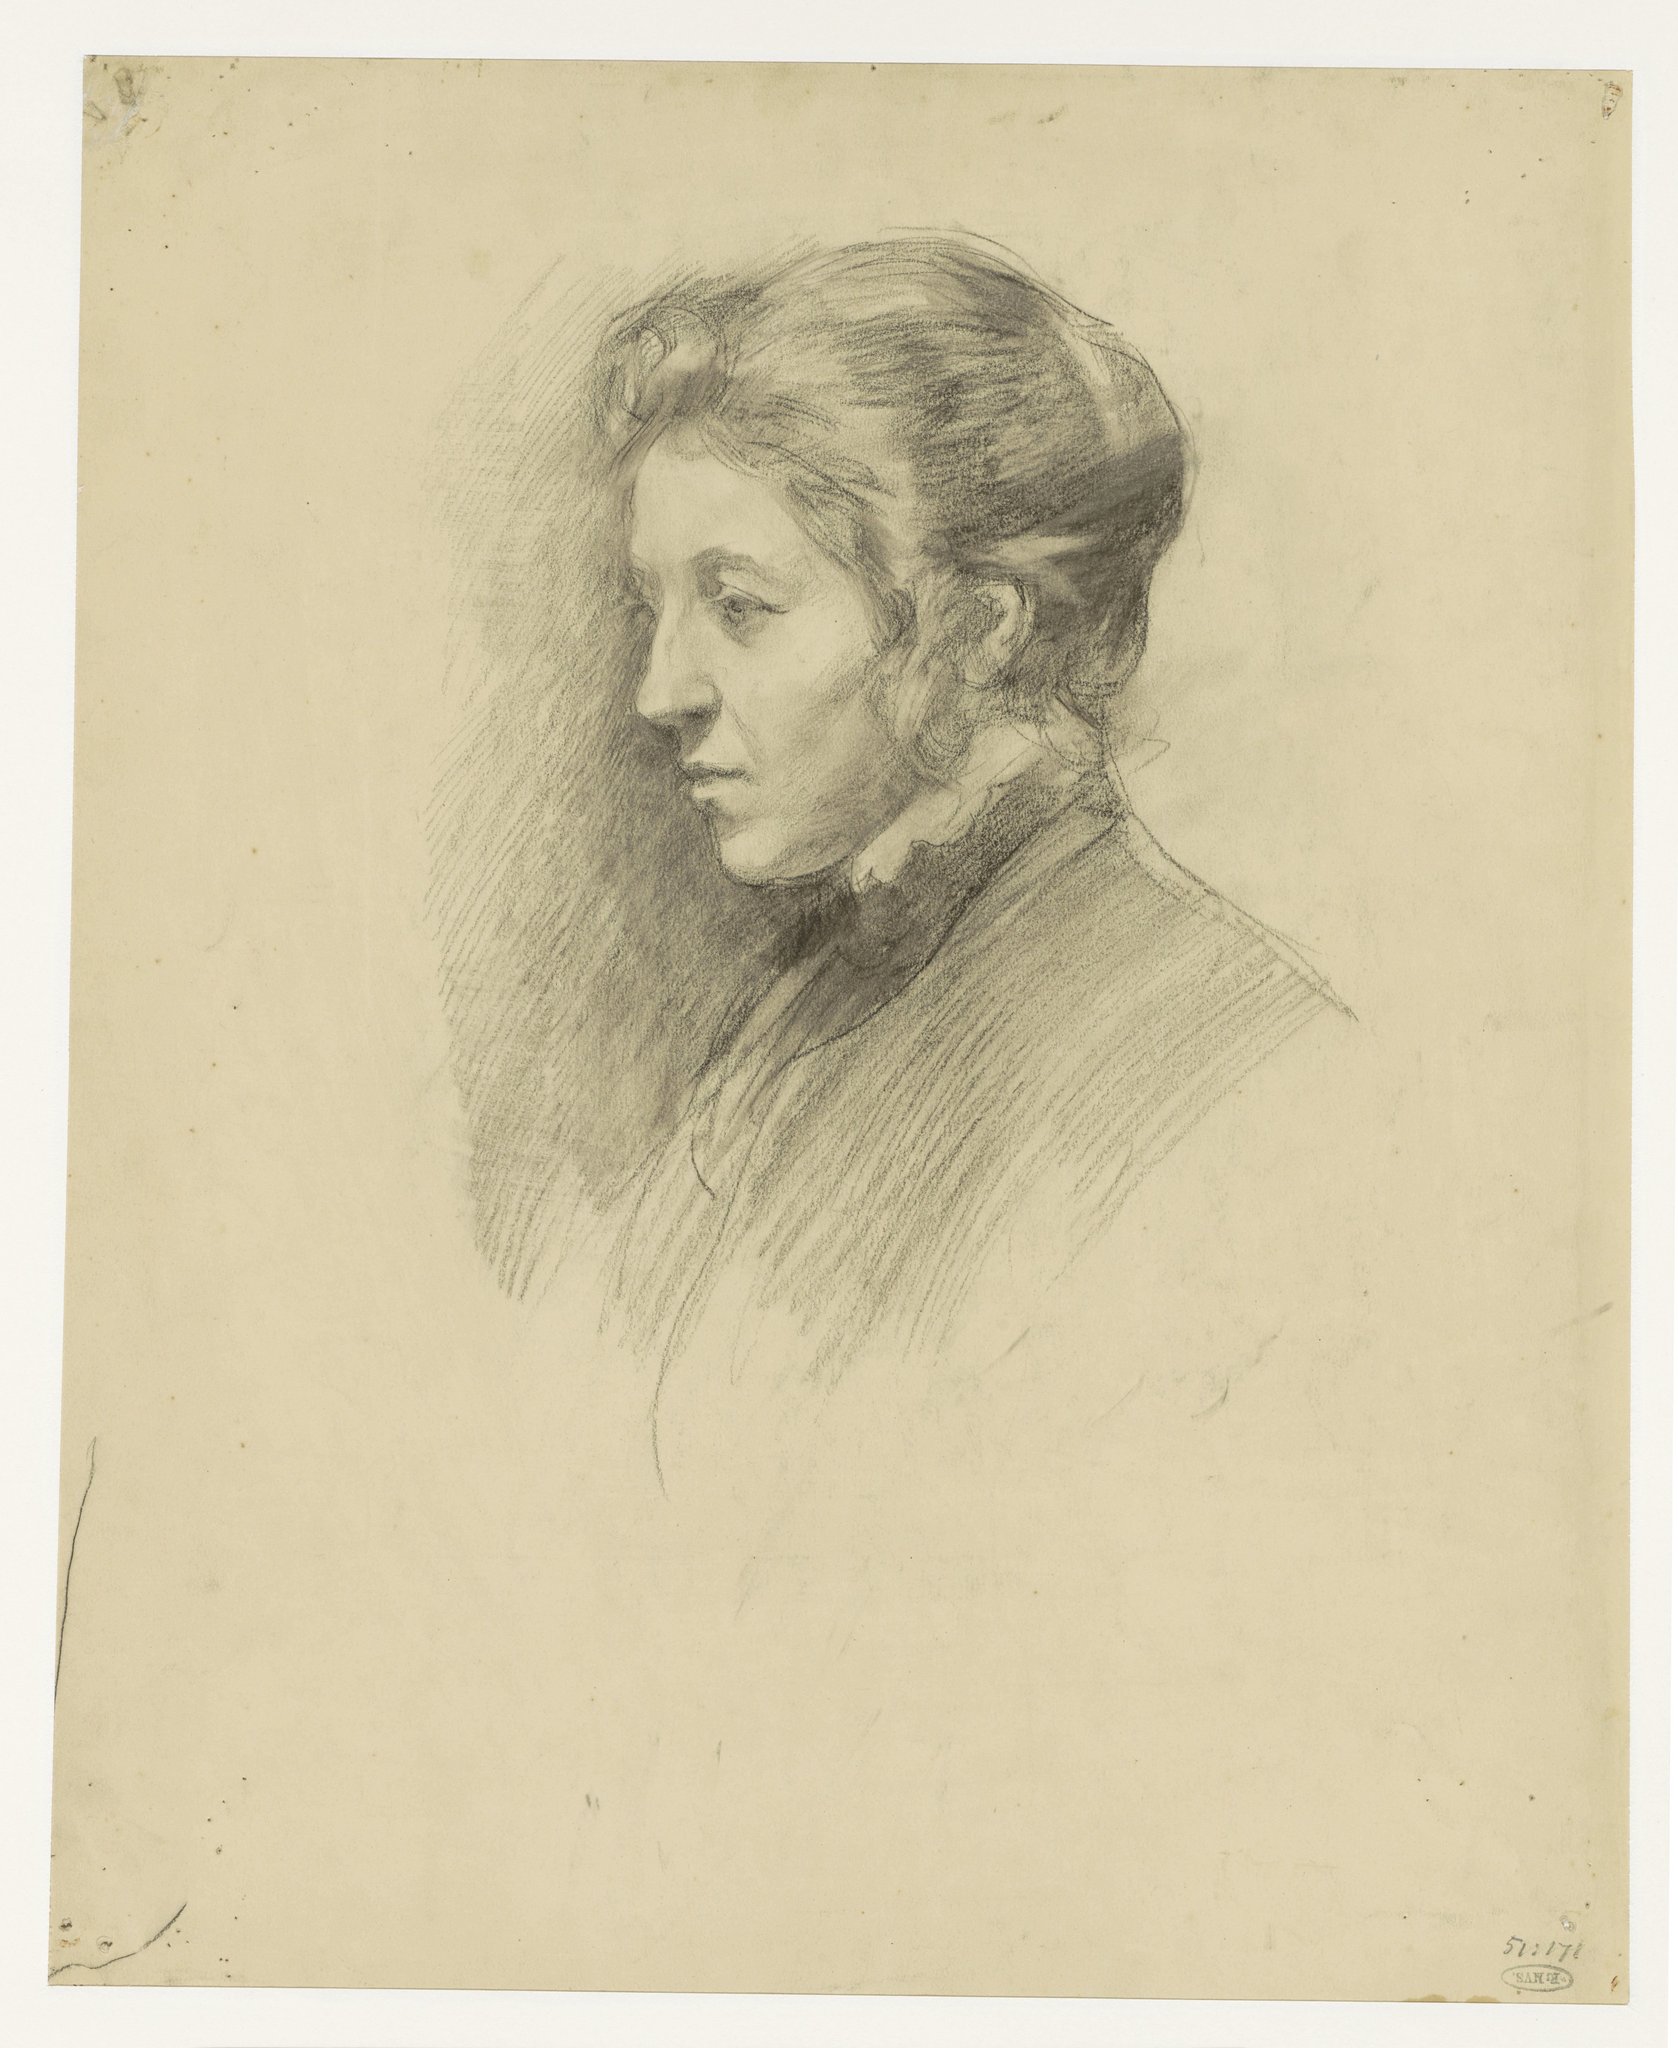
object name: drawing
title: Portret van Emilia Spoor-van Wickevoirt Crommelin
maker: cornelis spoor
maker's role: draughtsman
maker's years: 1867-1928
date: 1877-1928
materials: chalk, paper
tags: historical persons